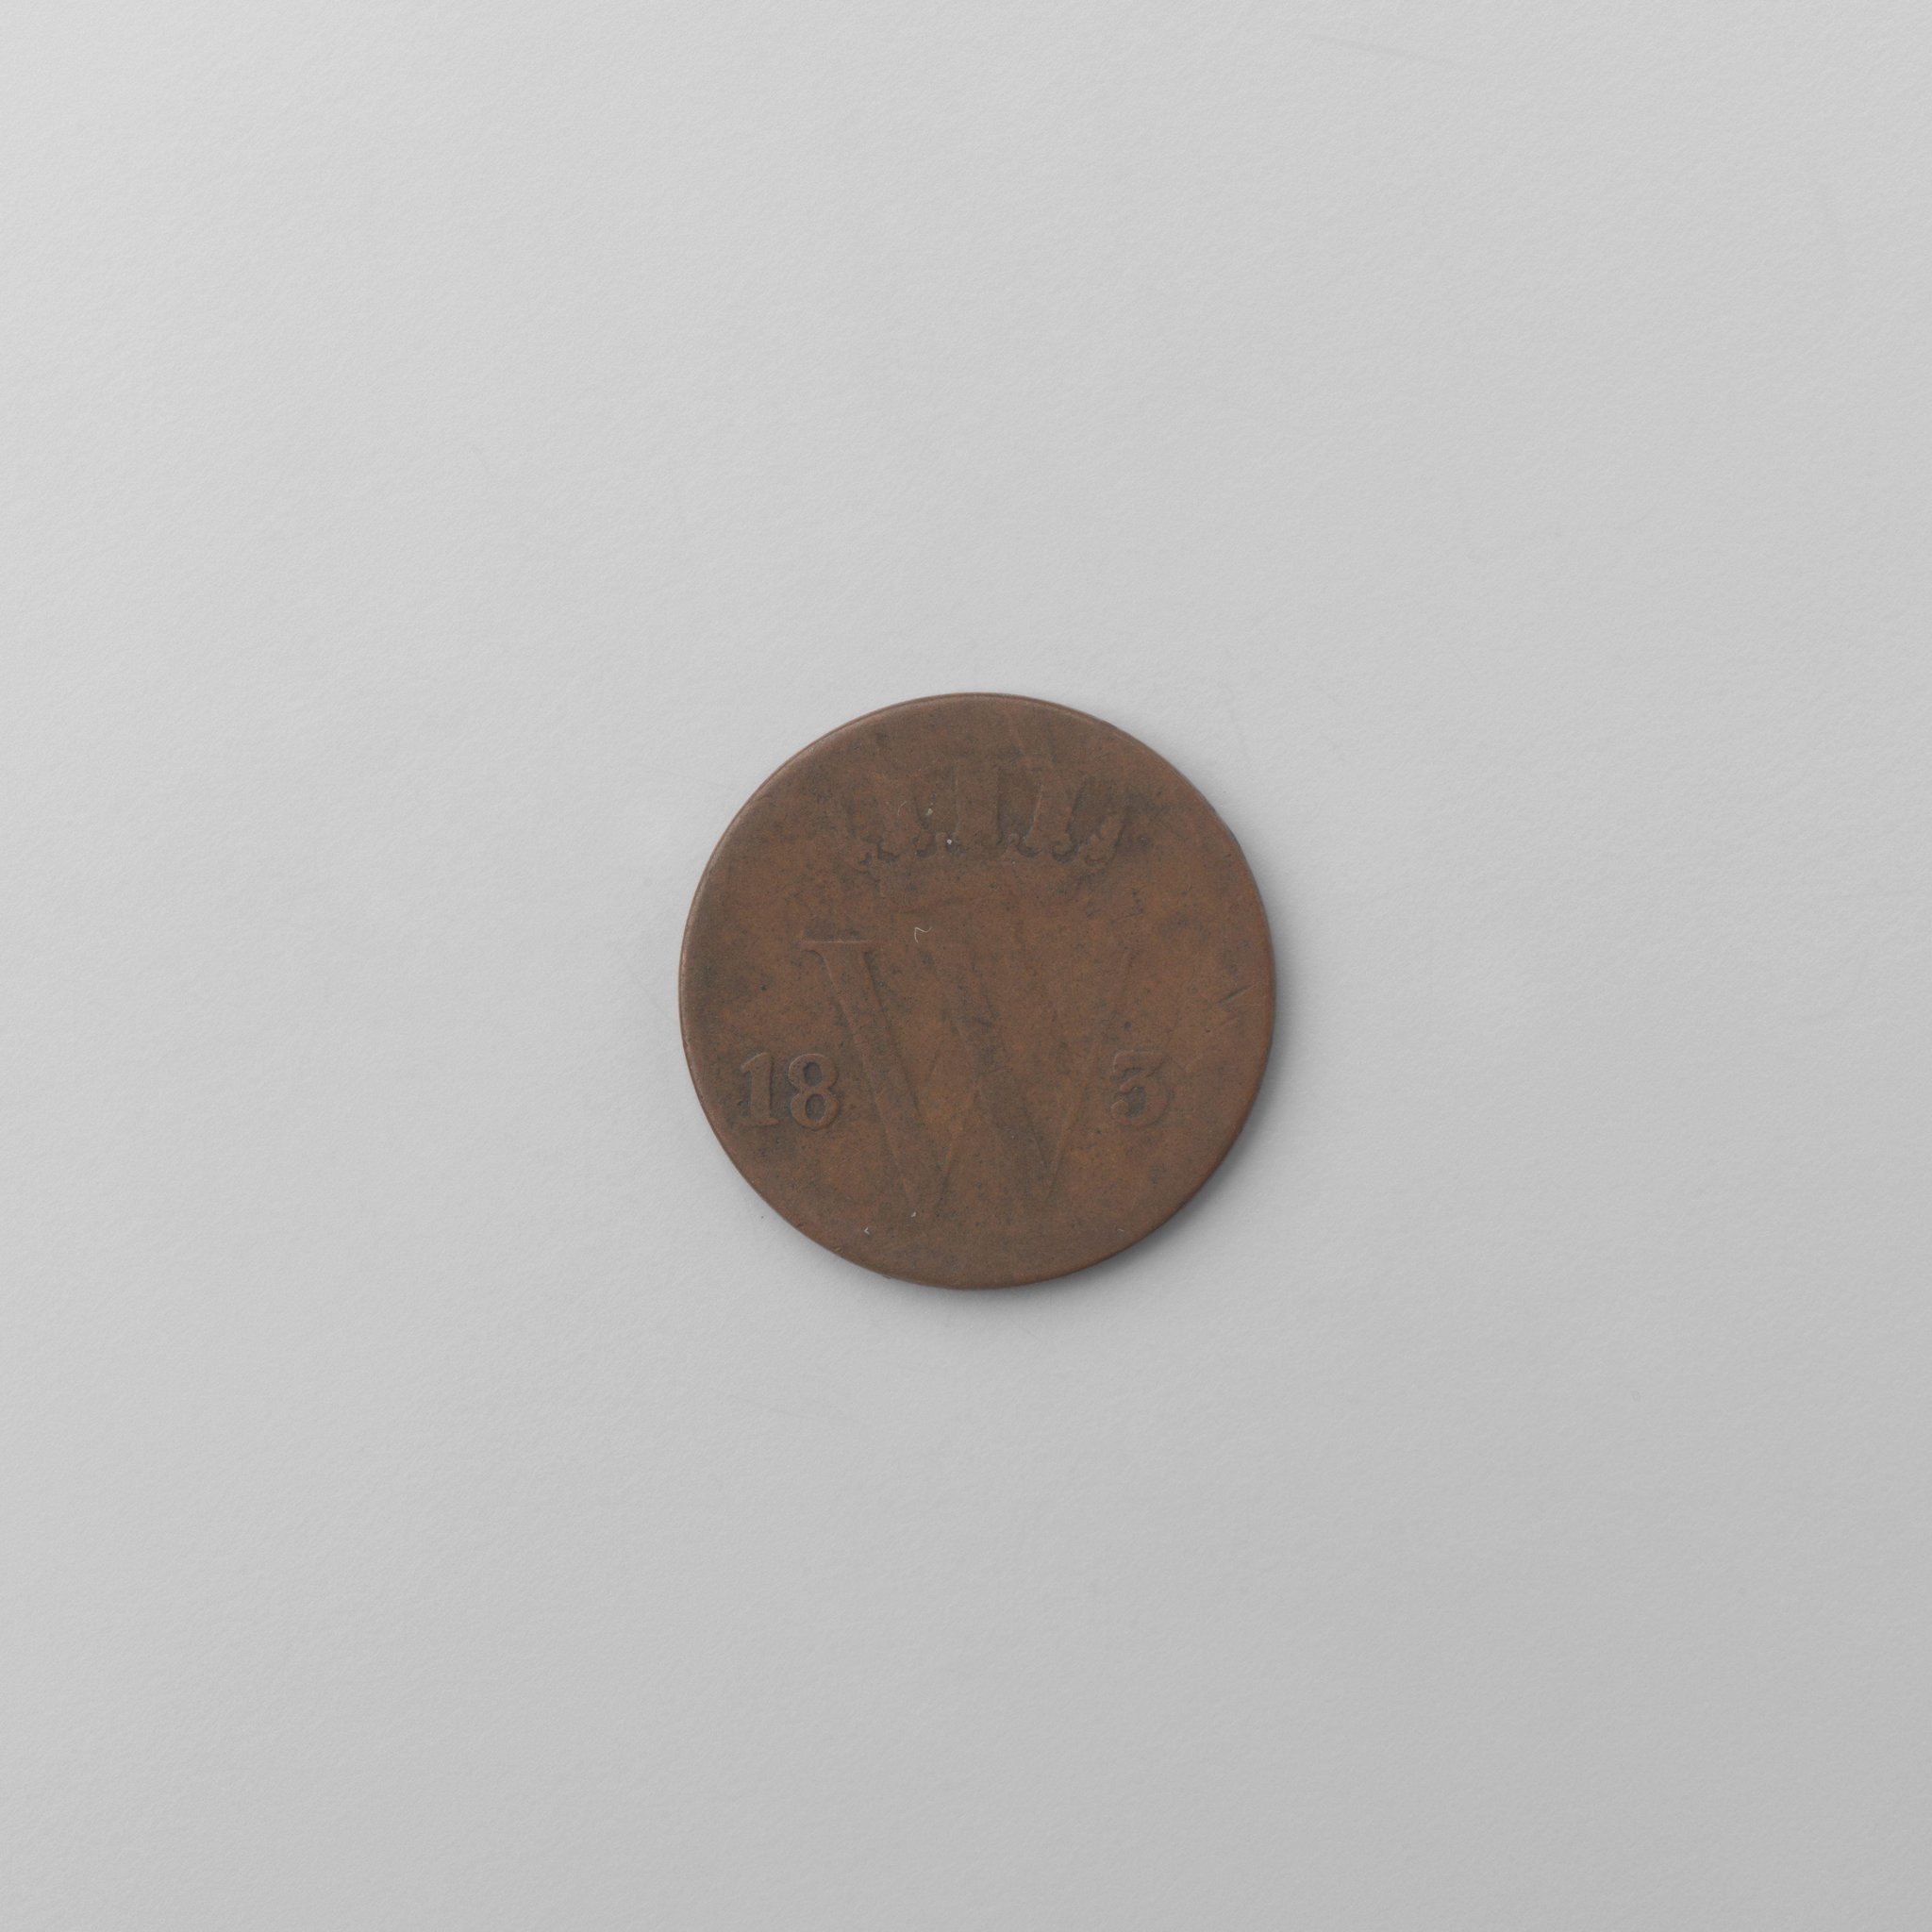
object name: coin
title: Nederlandse ½ cent, 1831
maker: william i of the netherlands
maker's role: koning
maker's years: 1772-1843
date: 1831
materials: copper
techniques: striking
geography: utrecht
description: Koperen munt. Voorzijde: tussen jaartal gekroonde rechte letter W. Keerzijde: tussen waarde-aanduiding ½ C. gekroond rijkswapenschild. Gladde rand.